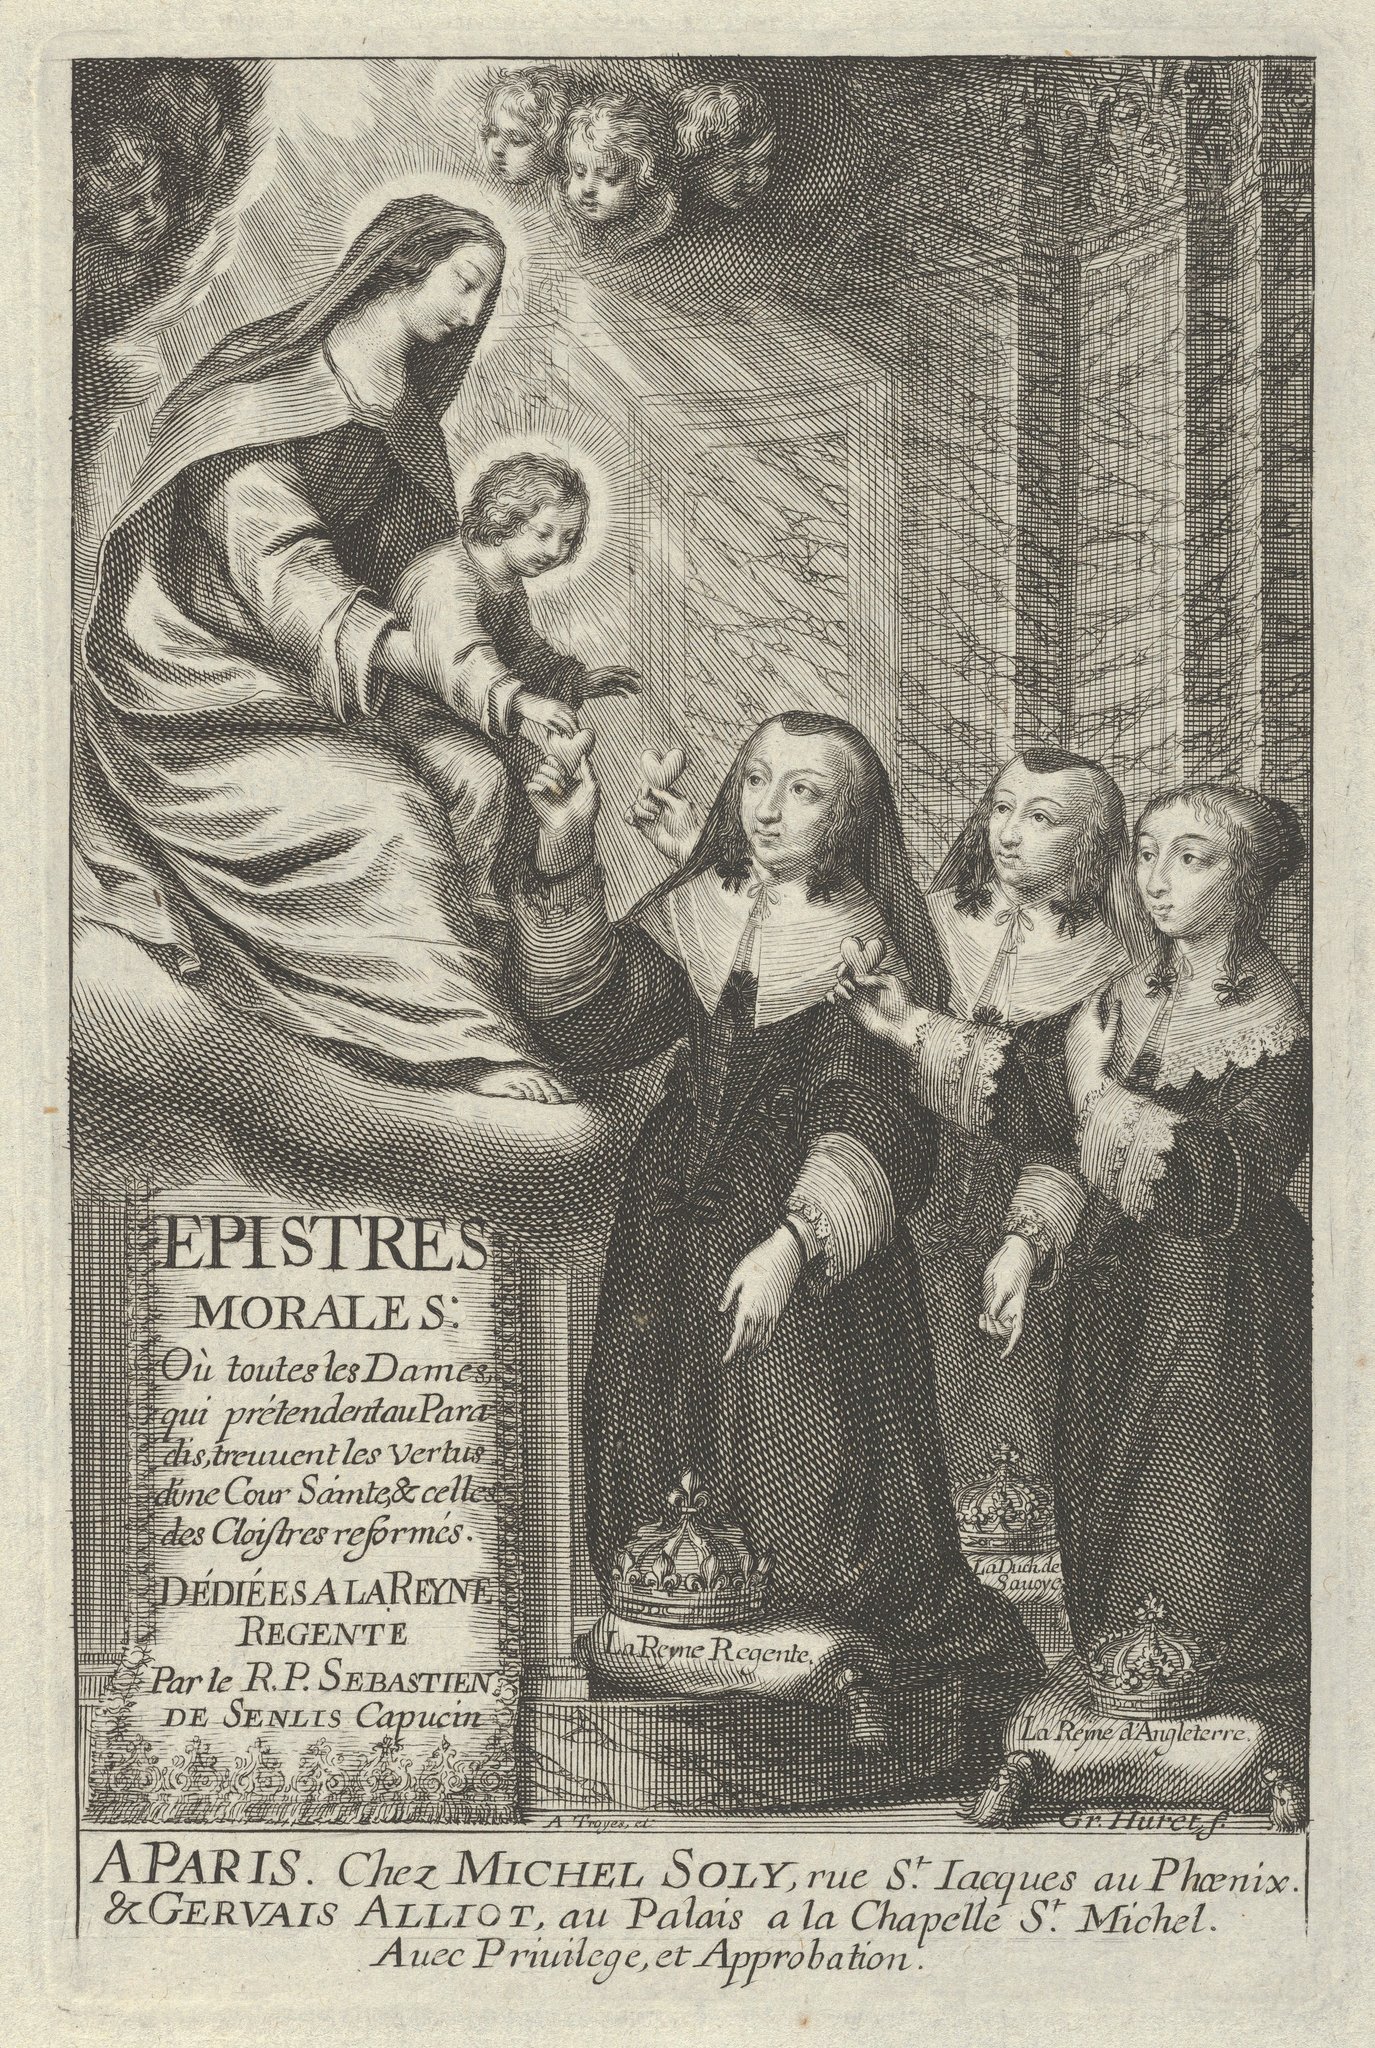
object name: print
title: Frontispiece from Epistre Morales [...]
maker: grégoire huret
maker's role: artist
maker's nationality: french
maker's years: 1606-1670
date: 1601-1700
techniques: engraving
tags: women,madonna and child